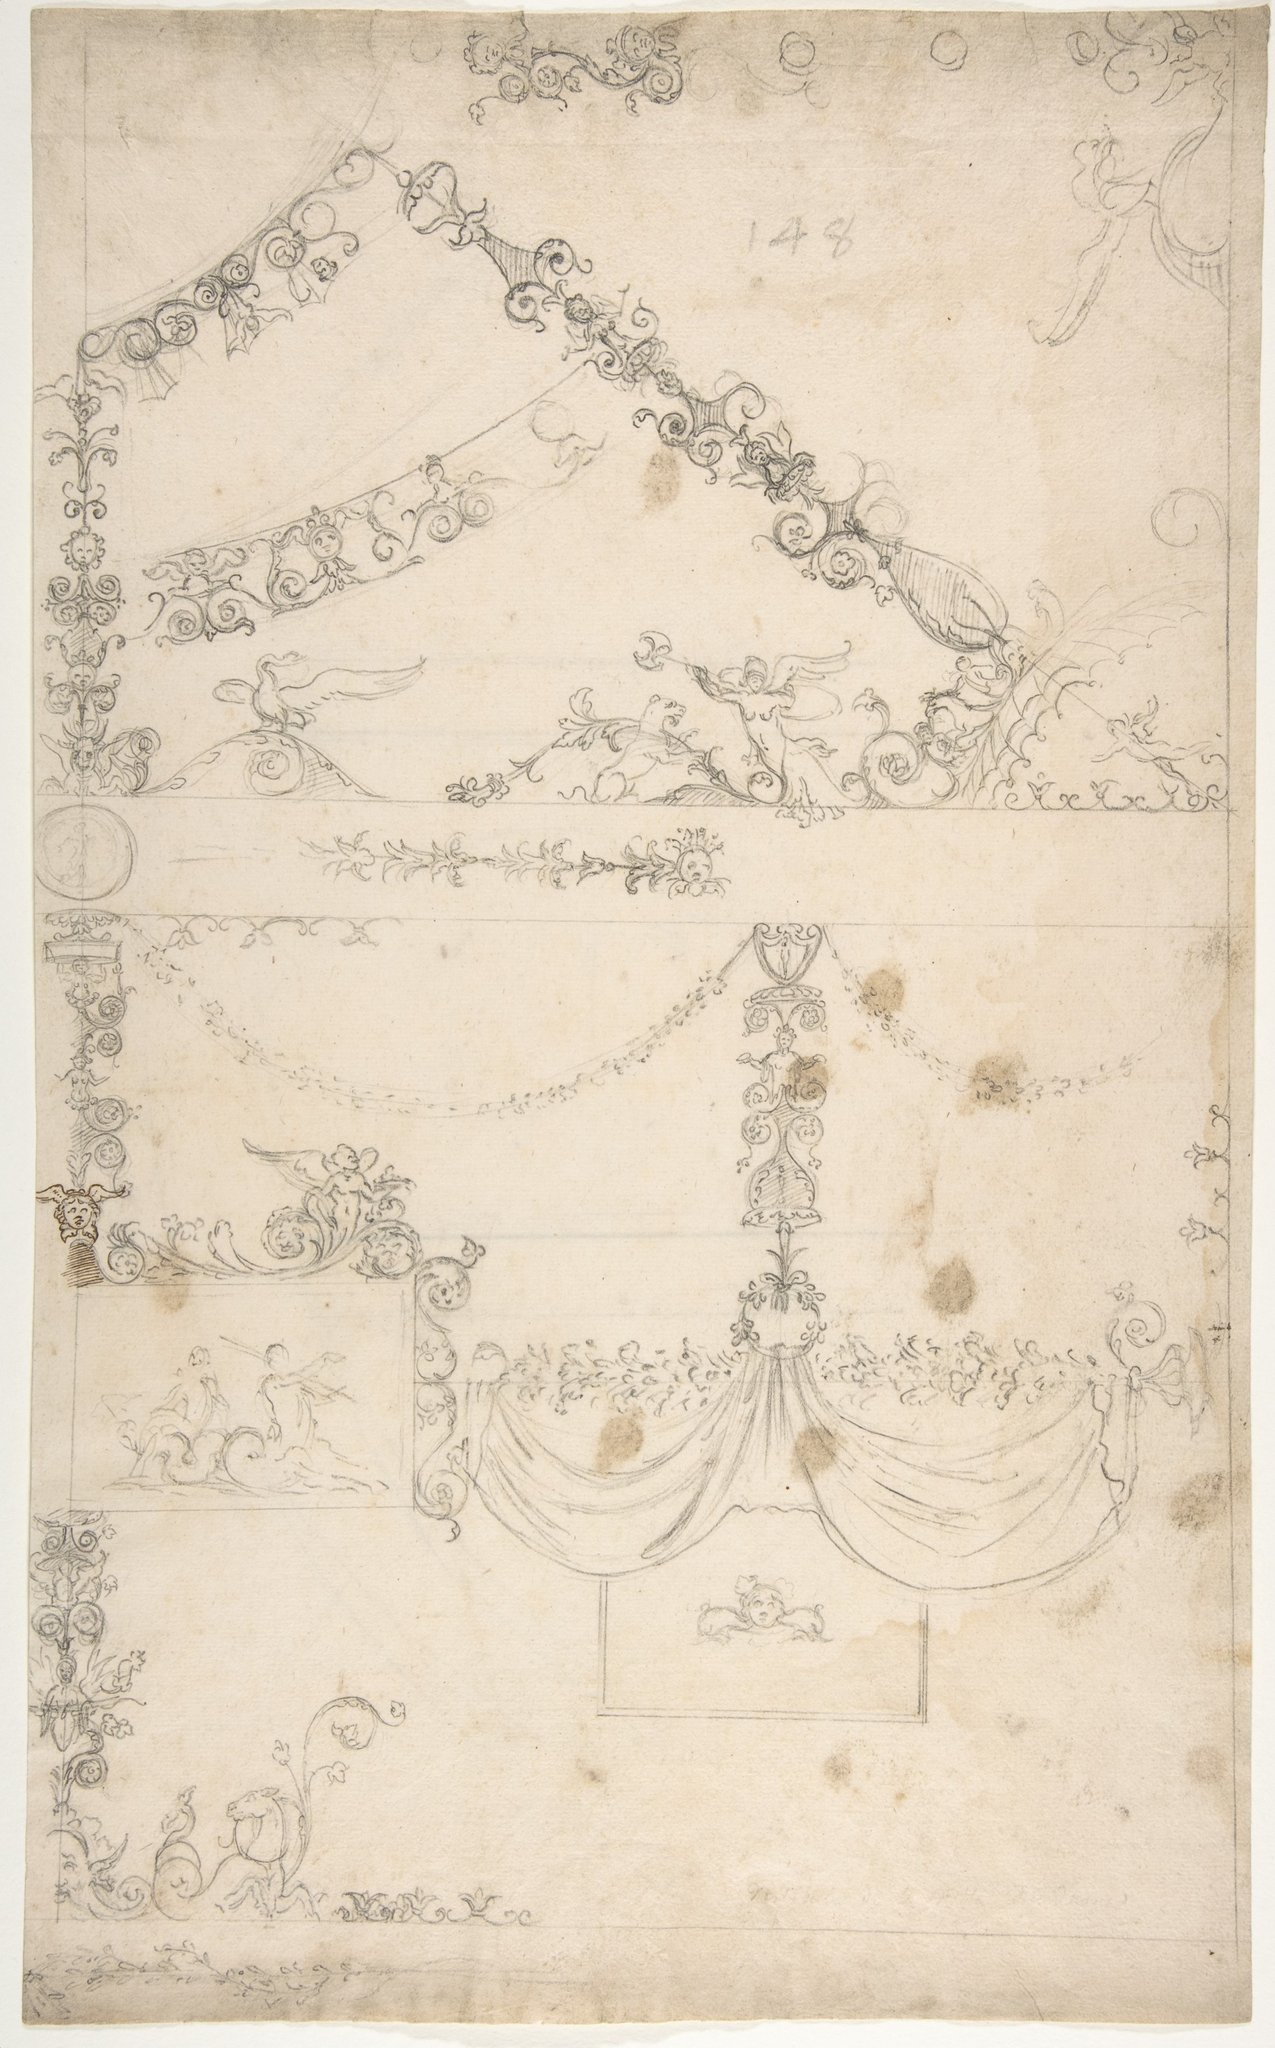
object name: collection ornament architecture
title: Domus Aurea, Volta Gialla, grotteschi, details (recto) Unidentified building, thermal window, elevation (verso)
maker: anonymous, french, 16th century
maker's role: draftsman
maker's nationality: french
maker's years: 1500-1600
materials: chalk, ink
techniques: incising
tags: garlands,grotesques,ornament,mythical creatures